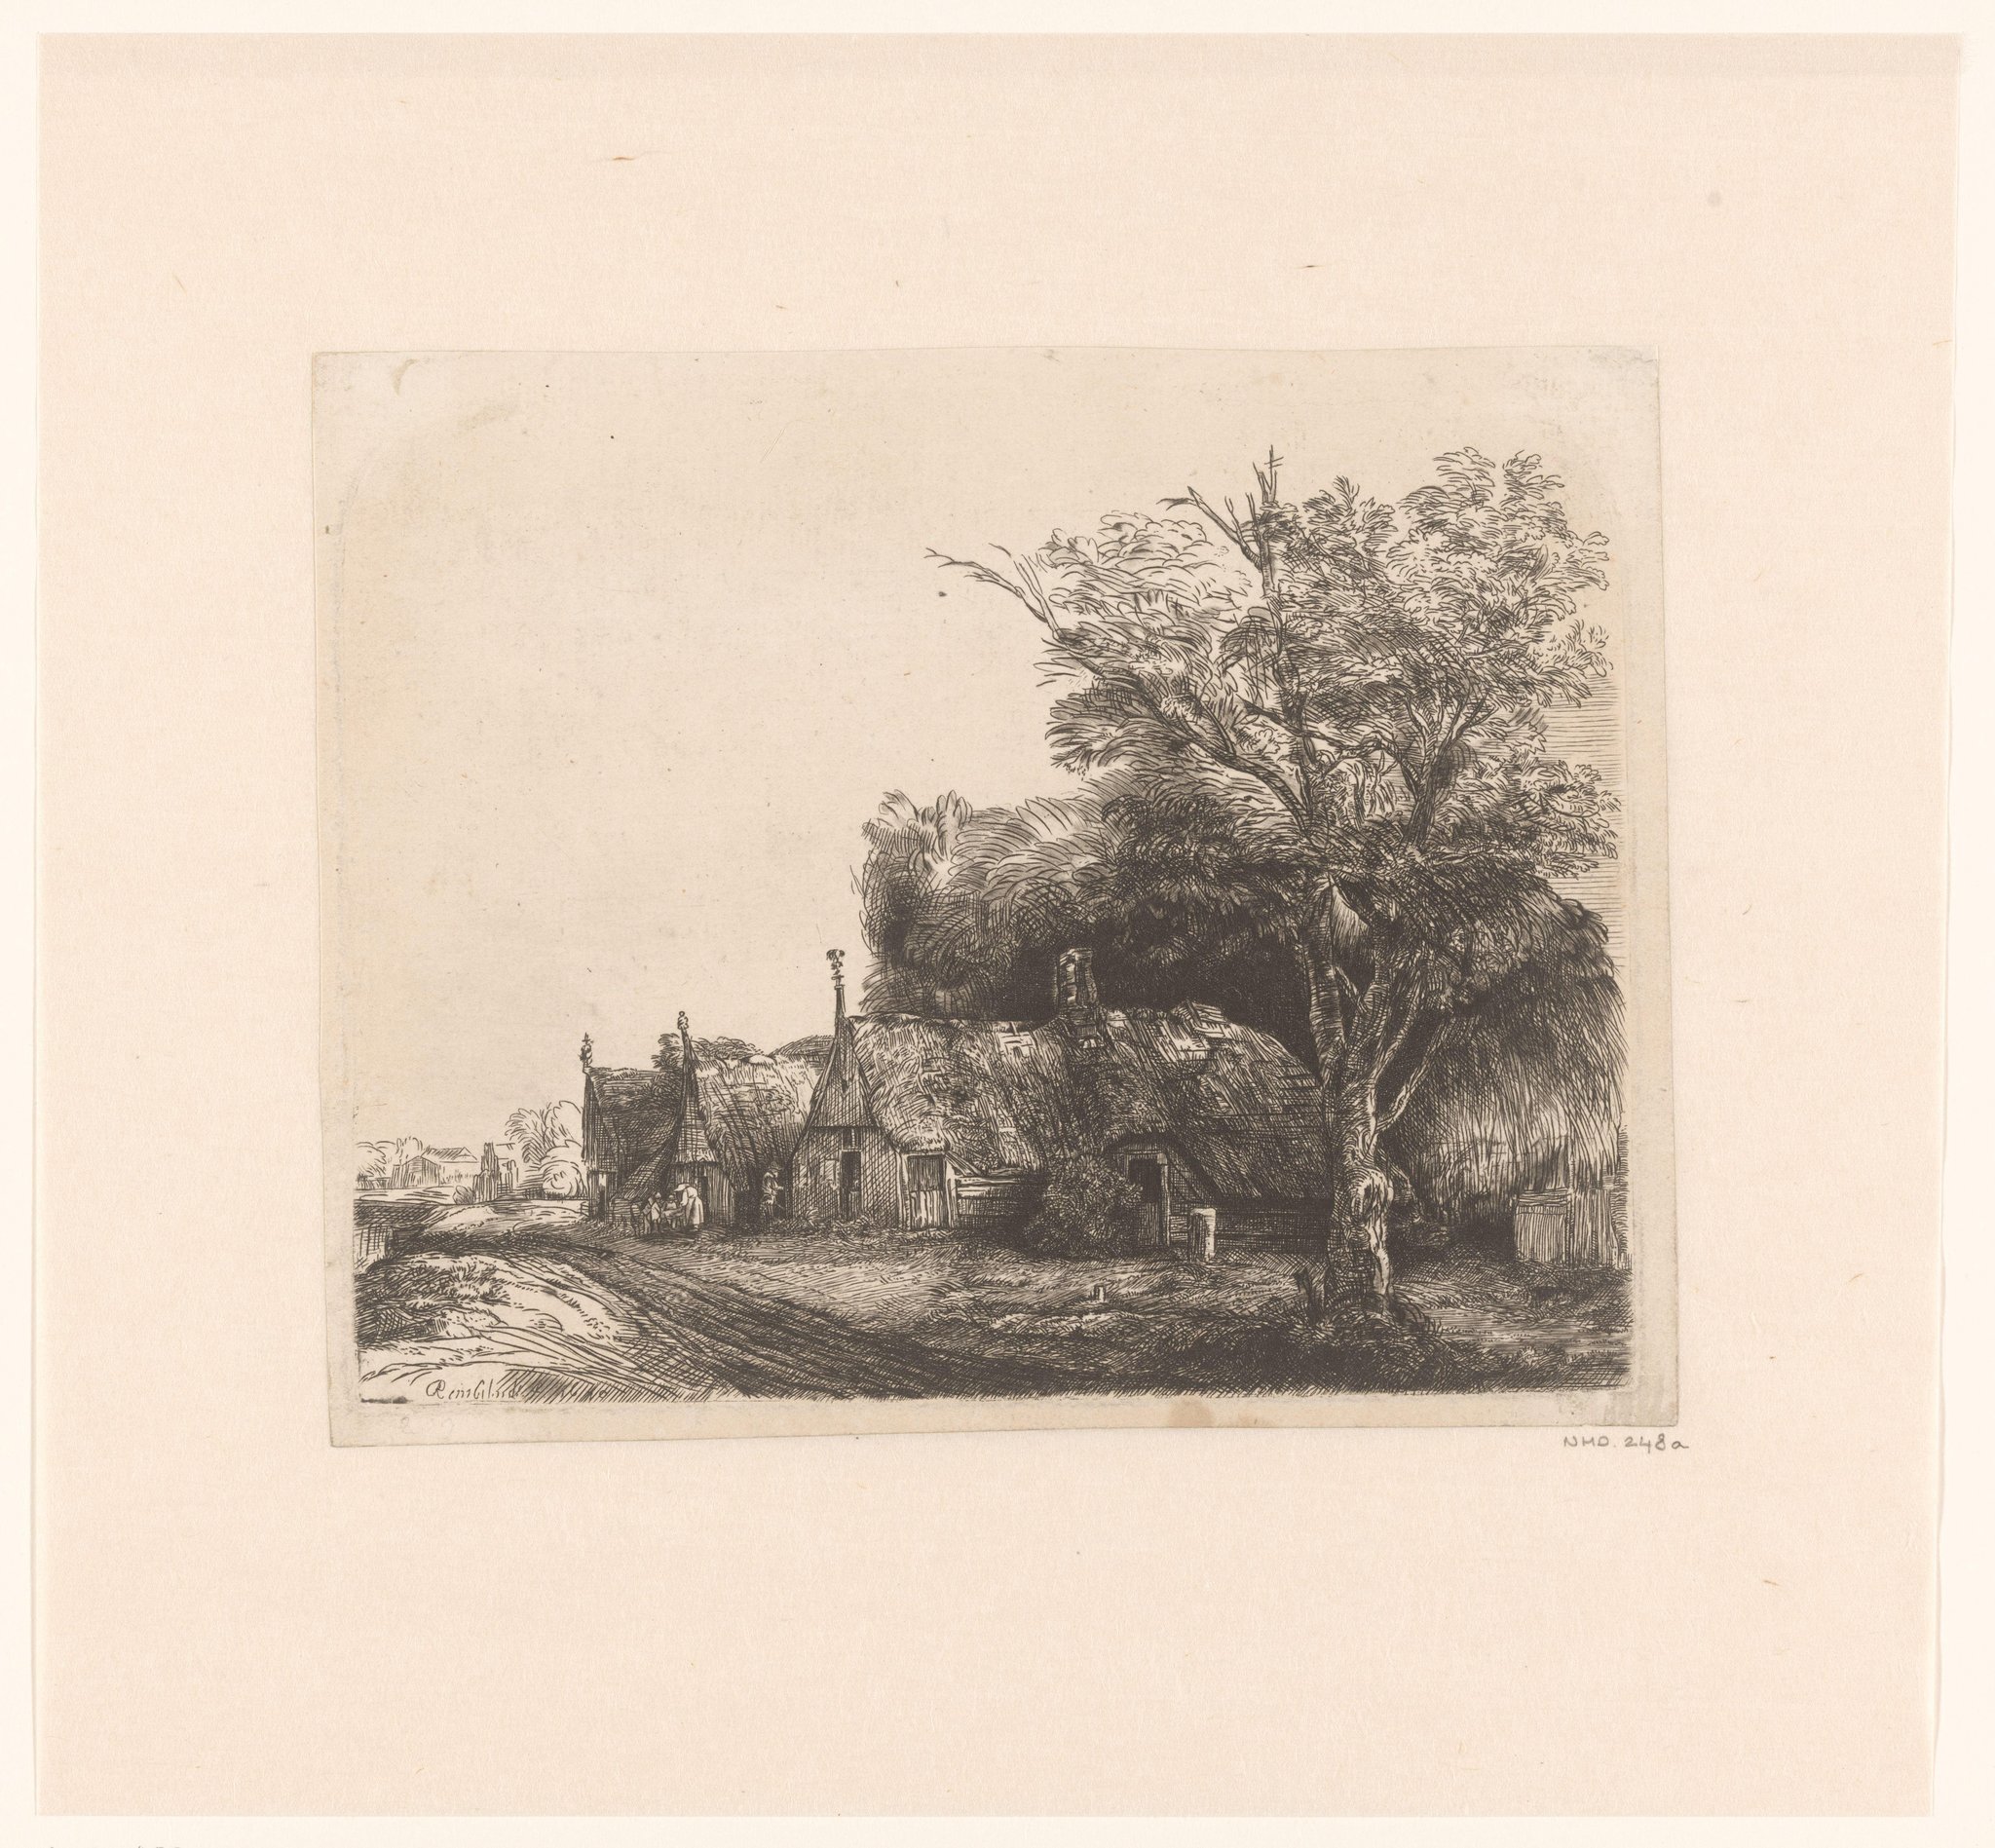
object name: print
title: Landscape with three gabled cottages beside a road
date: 1760-1781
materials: paper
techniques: etching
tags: city-view, and landscape with man-made constructions, hut, cabin, lodge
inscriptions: collector's mark: Lugt 2760, collector's mark: Lugt 2228